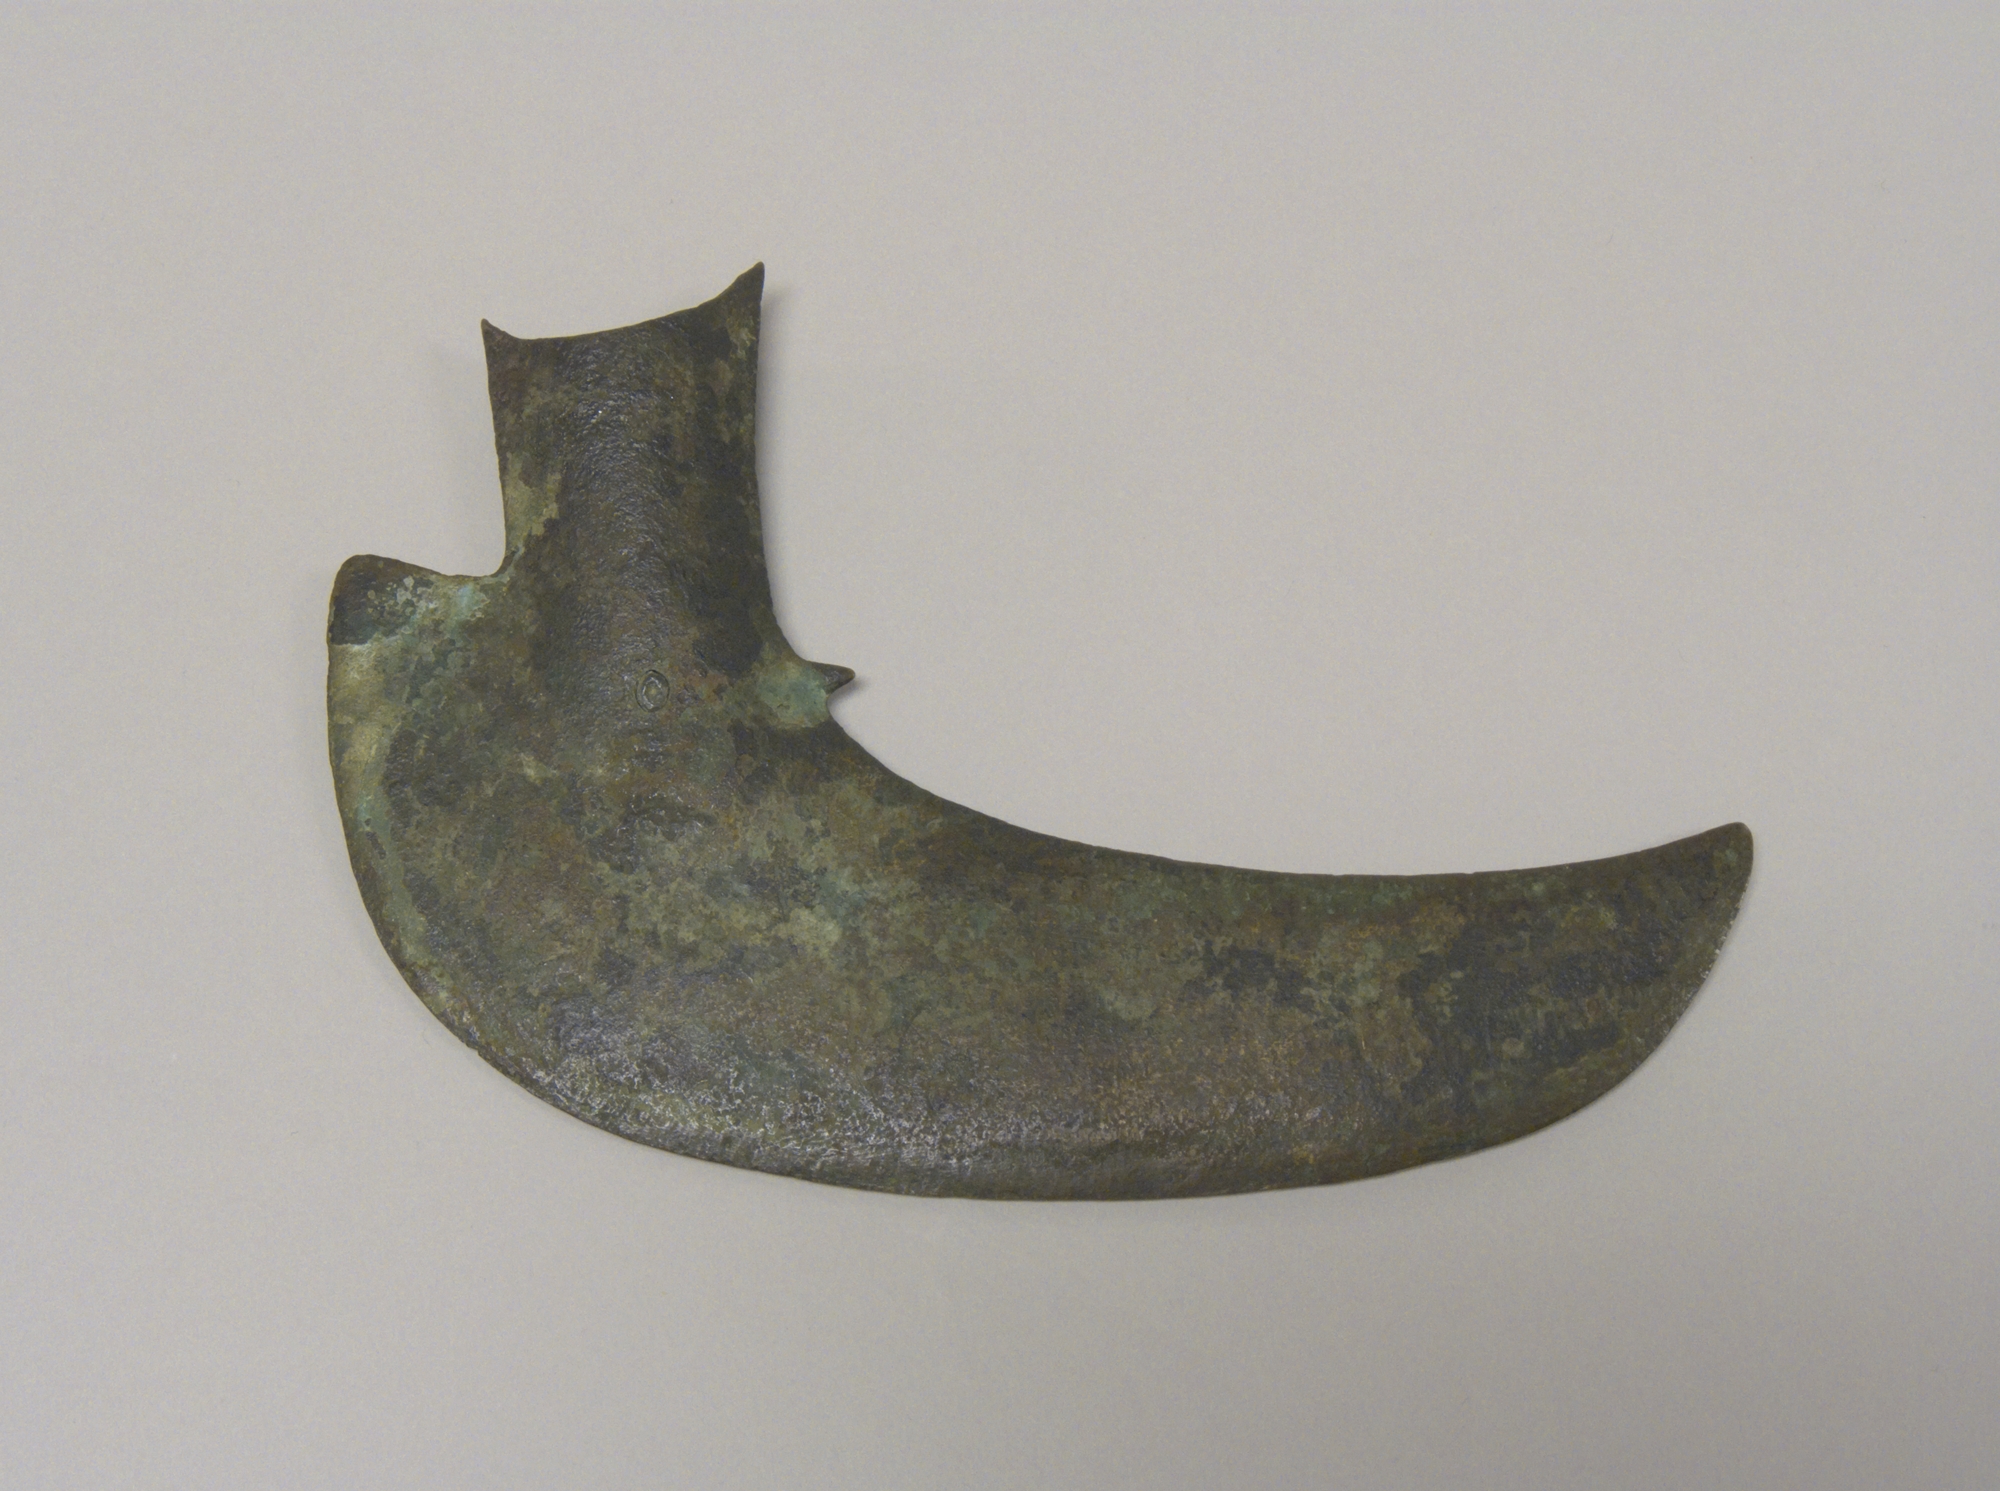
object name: hafted ax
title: Asymmetric Pediform Hafted Ax with Eye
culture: vietnamese or thai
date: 500 BCE-300 CE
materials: bronze